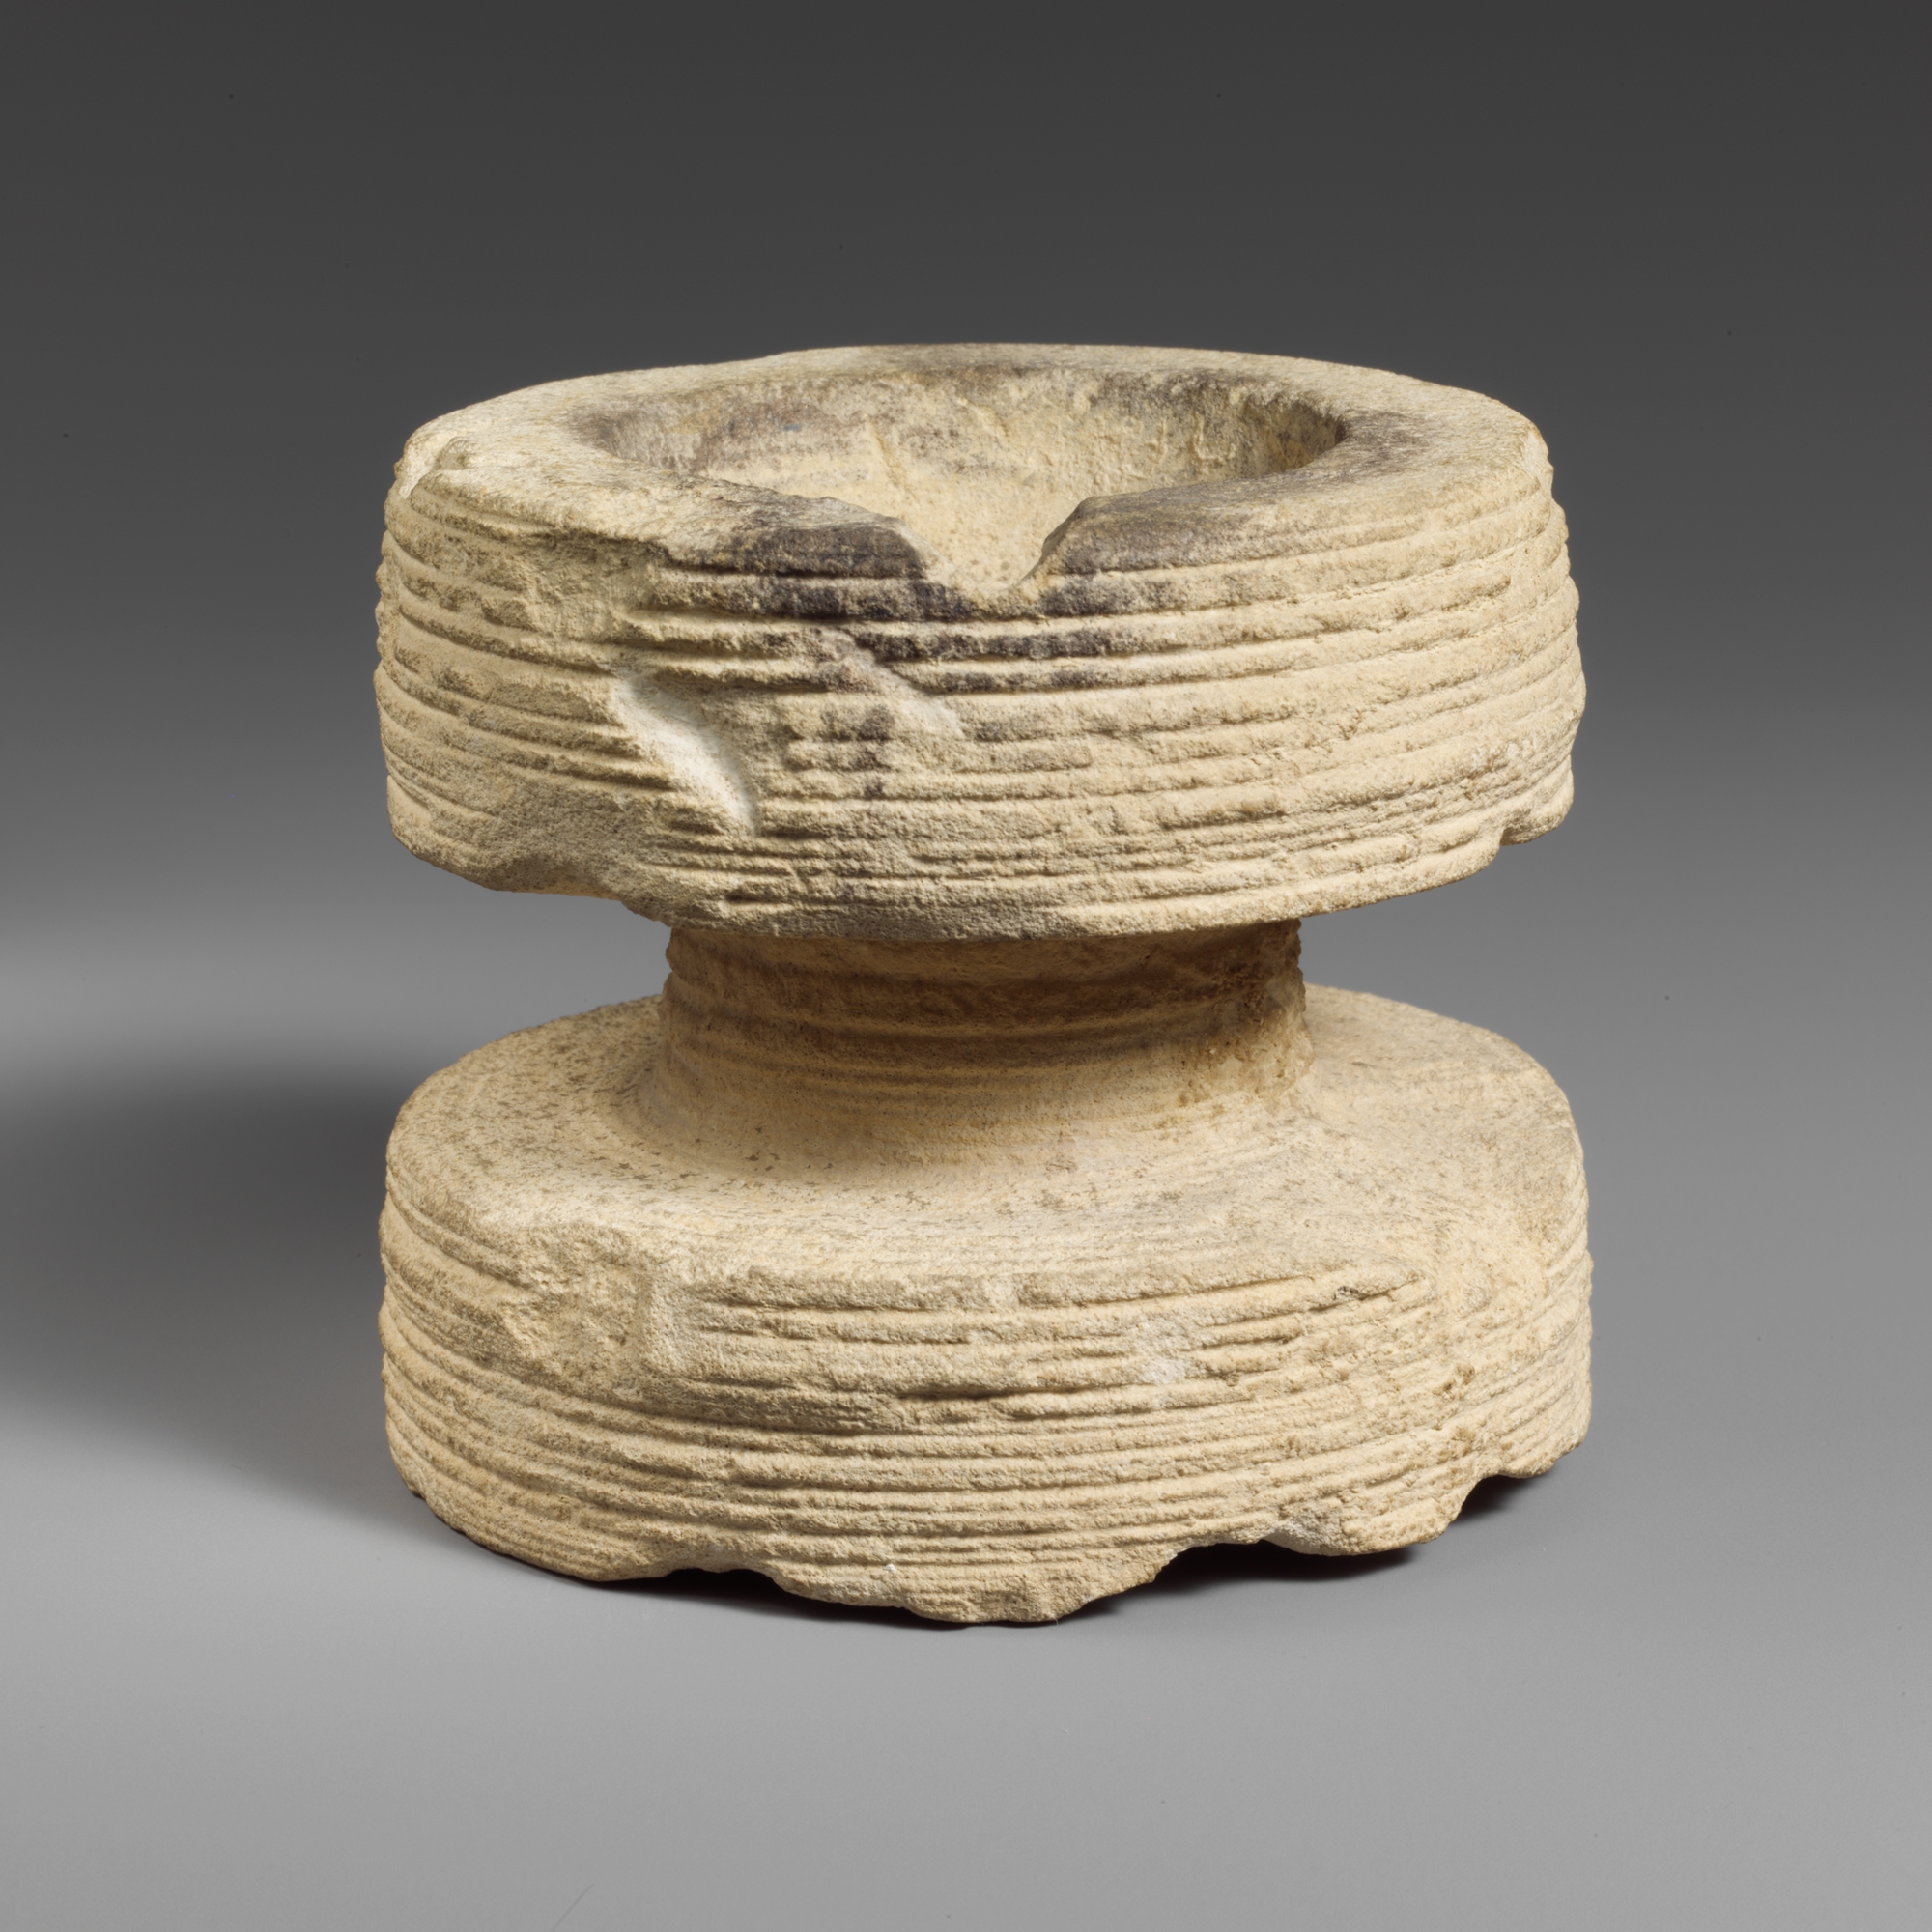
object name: lamp, columnar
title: Circular limestone incense burner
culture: cypriot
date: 3900 BCE-100 CE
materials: limestone